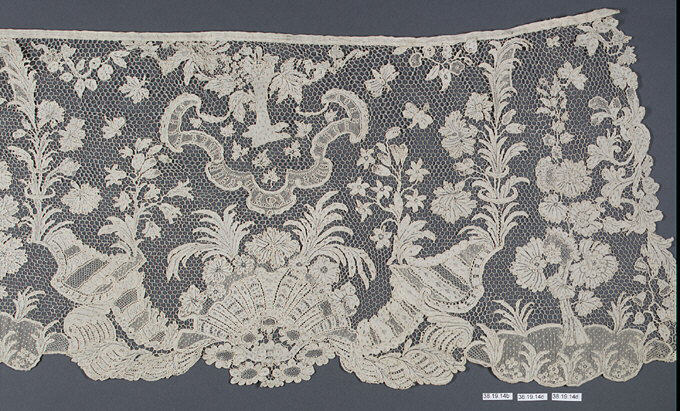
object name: flounce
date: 1715-1724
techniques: lace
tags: flowers